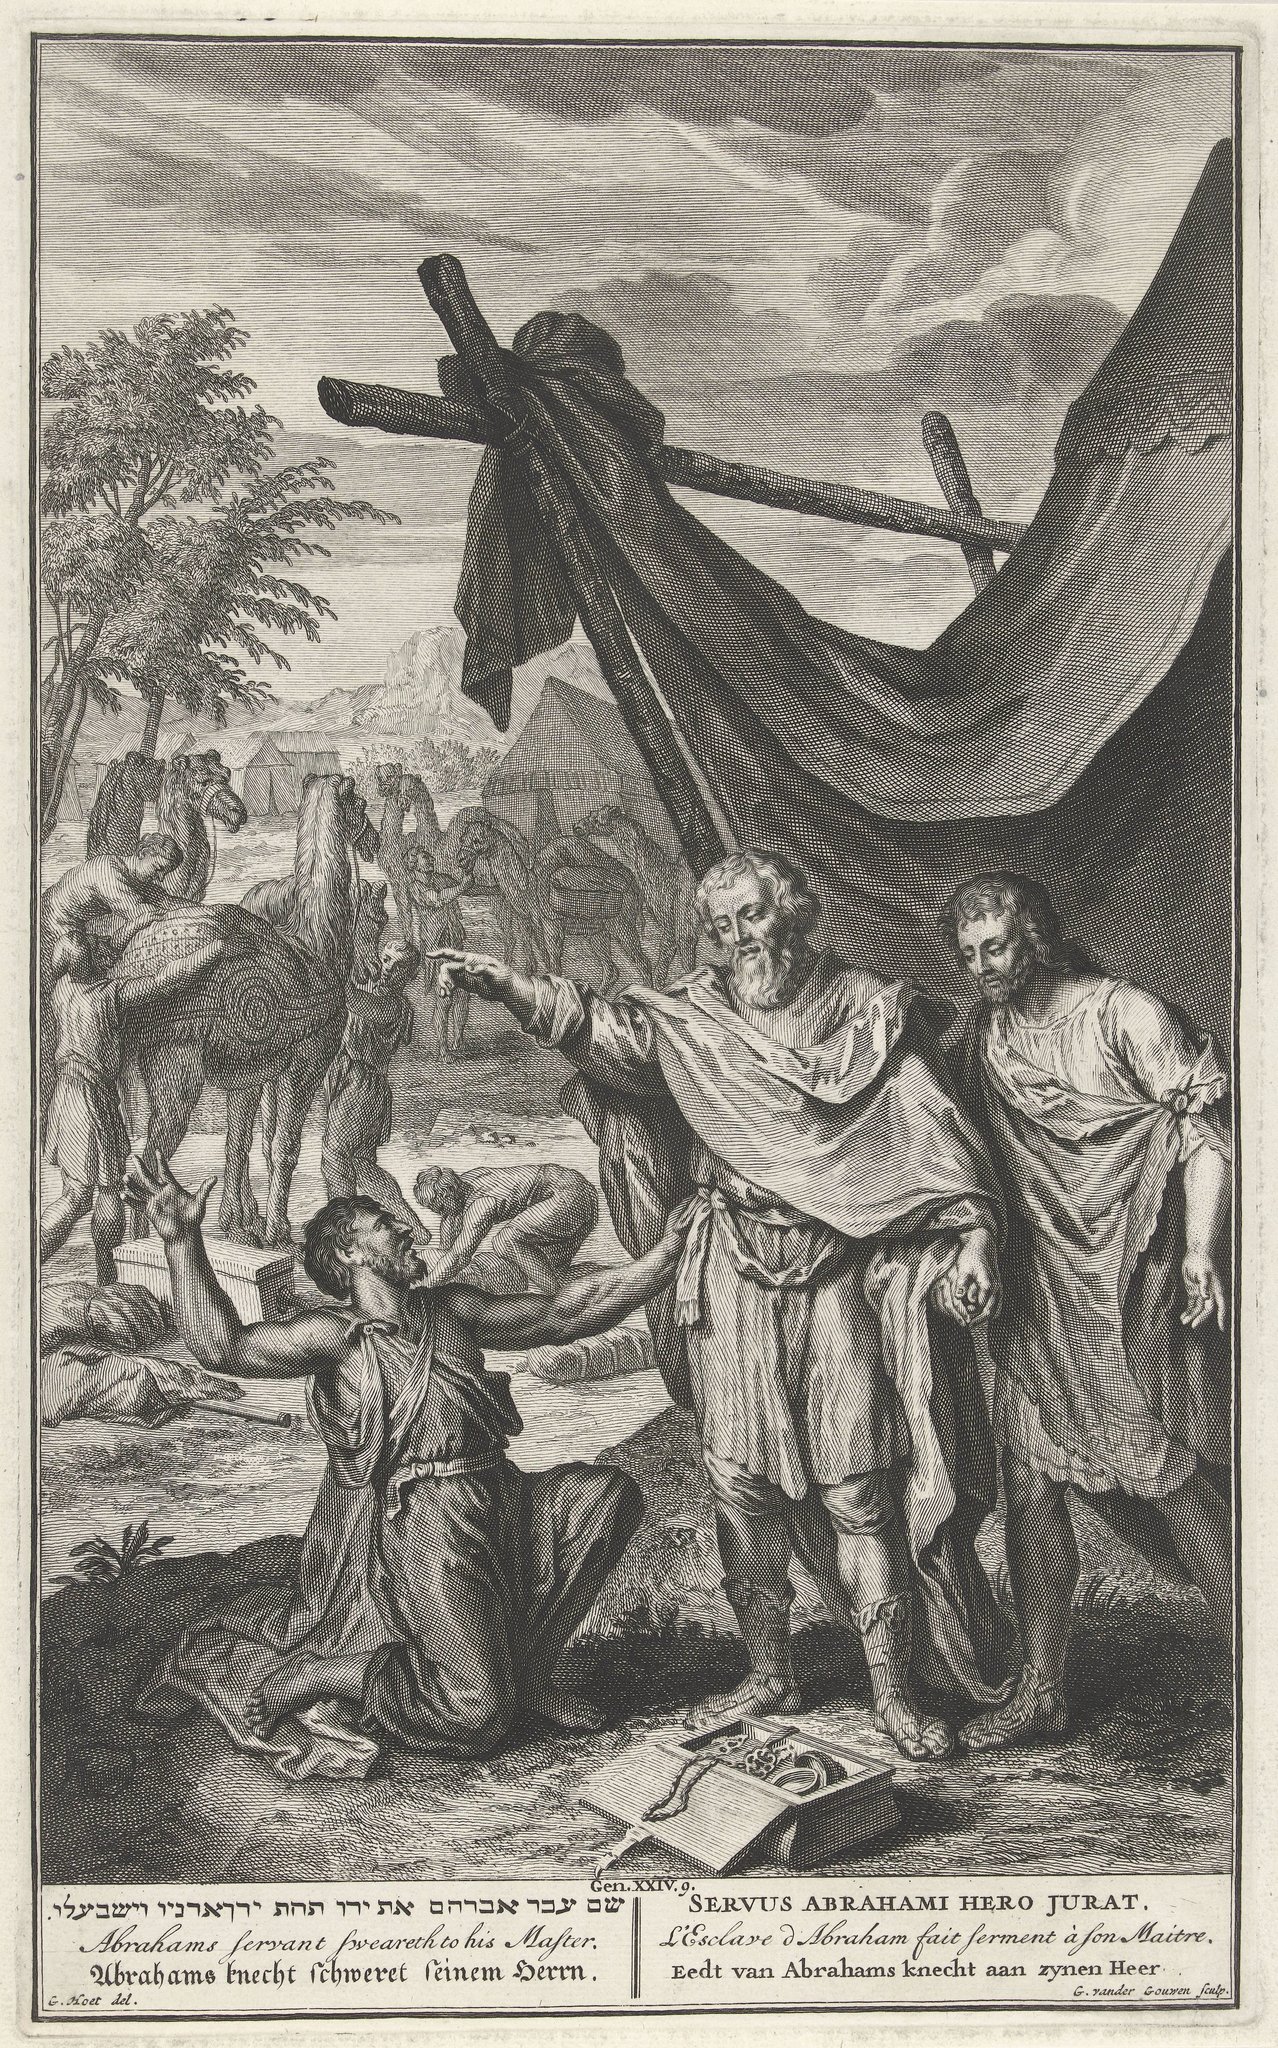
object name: print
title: Eliëzer belooft dat hij een vrouw voor Isaak zal vinden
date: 1728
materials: paper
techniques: engraving, etching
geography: the hague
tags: eliezer taking the oath: abraham sends him to his relatives in mesopotamia to find a wife for isaac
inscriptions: collector's mark: Lugt 2228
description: Eliëzer, de knecht van Abraham, zweert een eed en belooft dat hij een vrouw voor Isaak zal vinden (Gen. 24:9). Op de achtergrond maken andere knechten kamelen klaar voor de reis. De prent heeft een Hebreeuws, Latijns, Frans, Engels, Duits en Nederlands onderschrift.